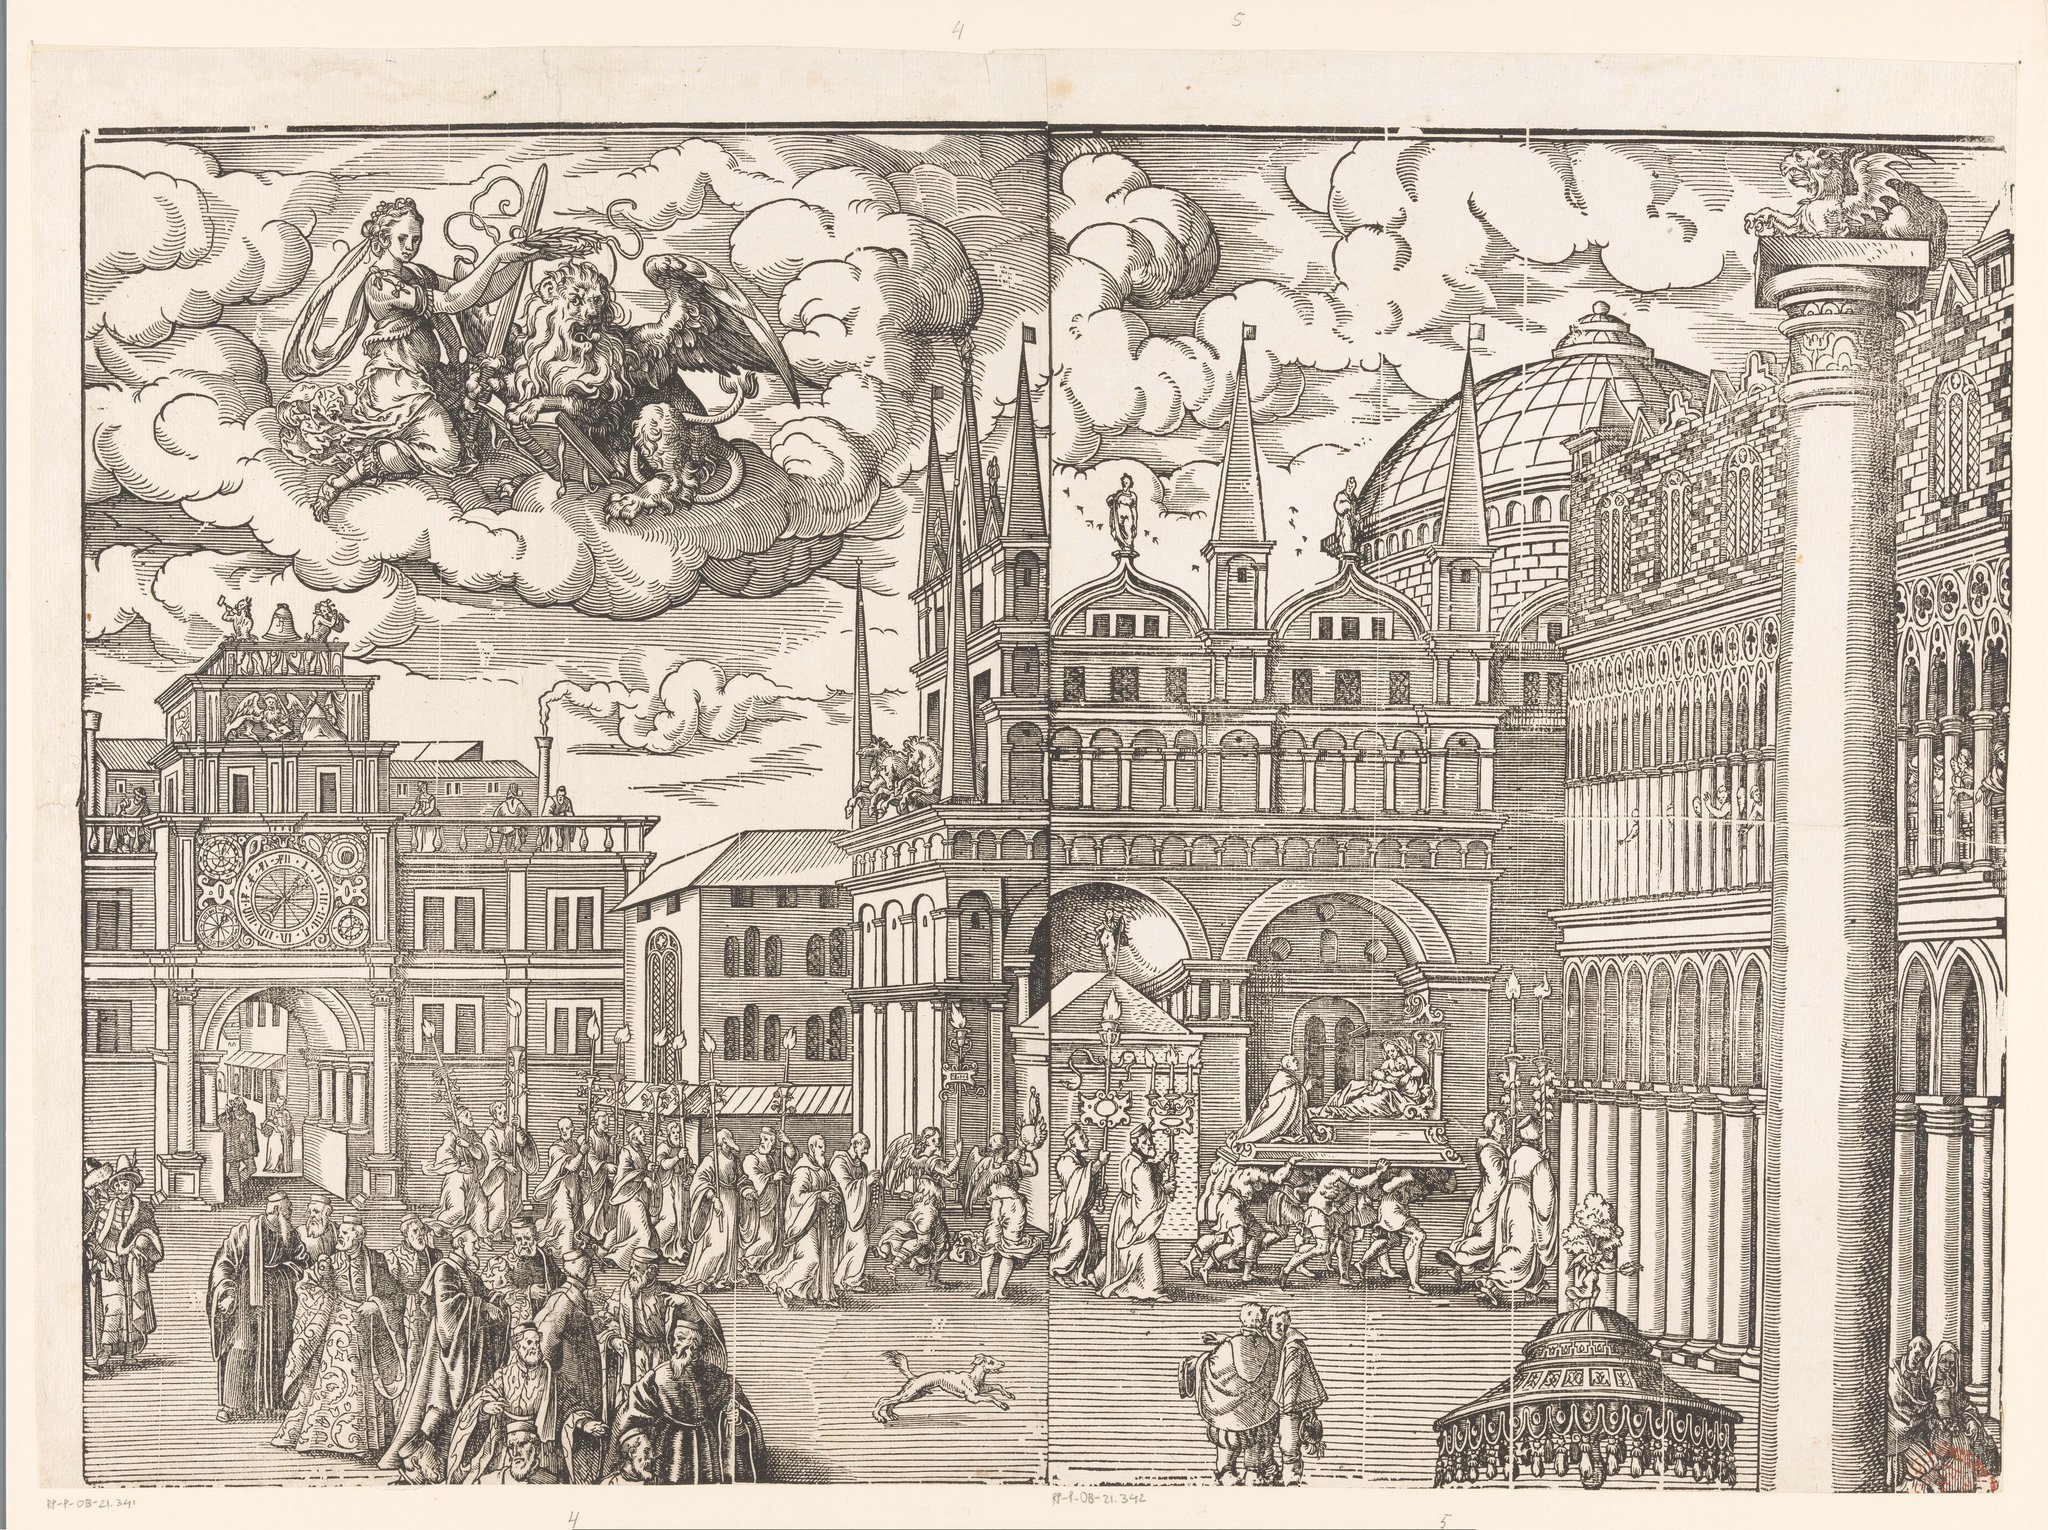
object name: print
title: Festa della Sensa (vijfde gedeelte)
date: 1679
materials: paper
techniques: woodcut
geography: frankfurt am main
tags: city-view in general; 'veduta', procession ~ christian religion, gondola, venice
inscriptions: collector's mark: Lugt 240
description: Vijfde gedeelte van een grote voorstelling van de Festa della Sensa. De voorstelling is gedrukt van veertien blokken, de titel van vijf blokken en het onderschrift bestaat uit vijf delen van elk drie kolommen Duits tekst. De veertien blokken die samen de voorstelling vormen zijn in de titels met de klok mee vanaf linksboven genummerd. In de collectie Rijksmuseum bevinden zich twee complete exemplaren inclusief titel en onderschrift. Omdat niet alle delen van de titel en het onderschrift op afzonderlijke bladen zijn gedrukt, is dit exemplaar niet virtueel samengevoegd omwille van een betere presentatie. Zie voor het andere exemplaar: RP-P-2017-6073.